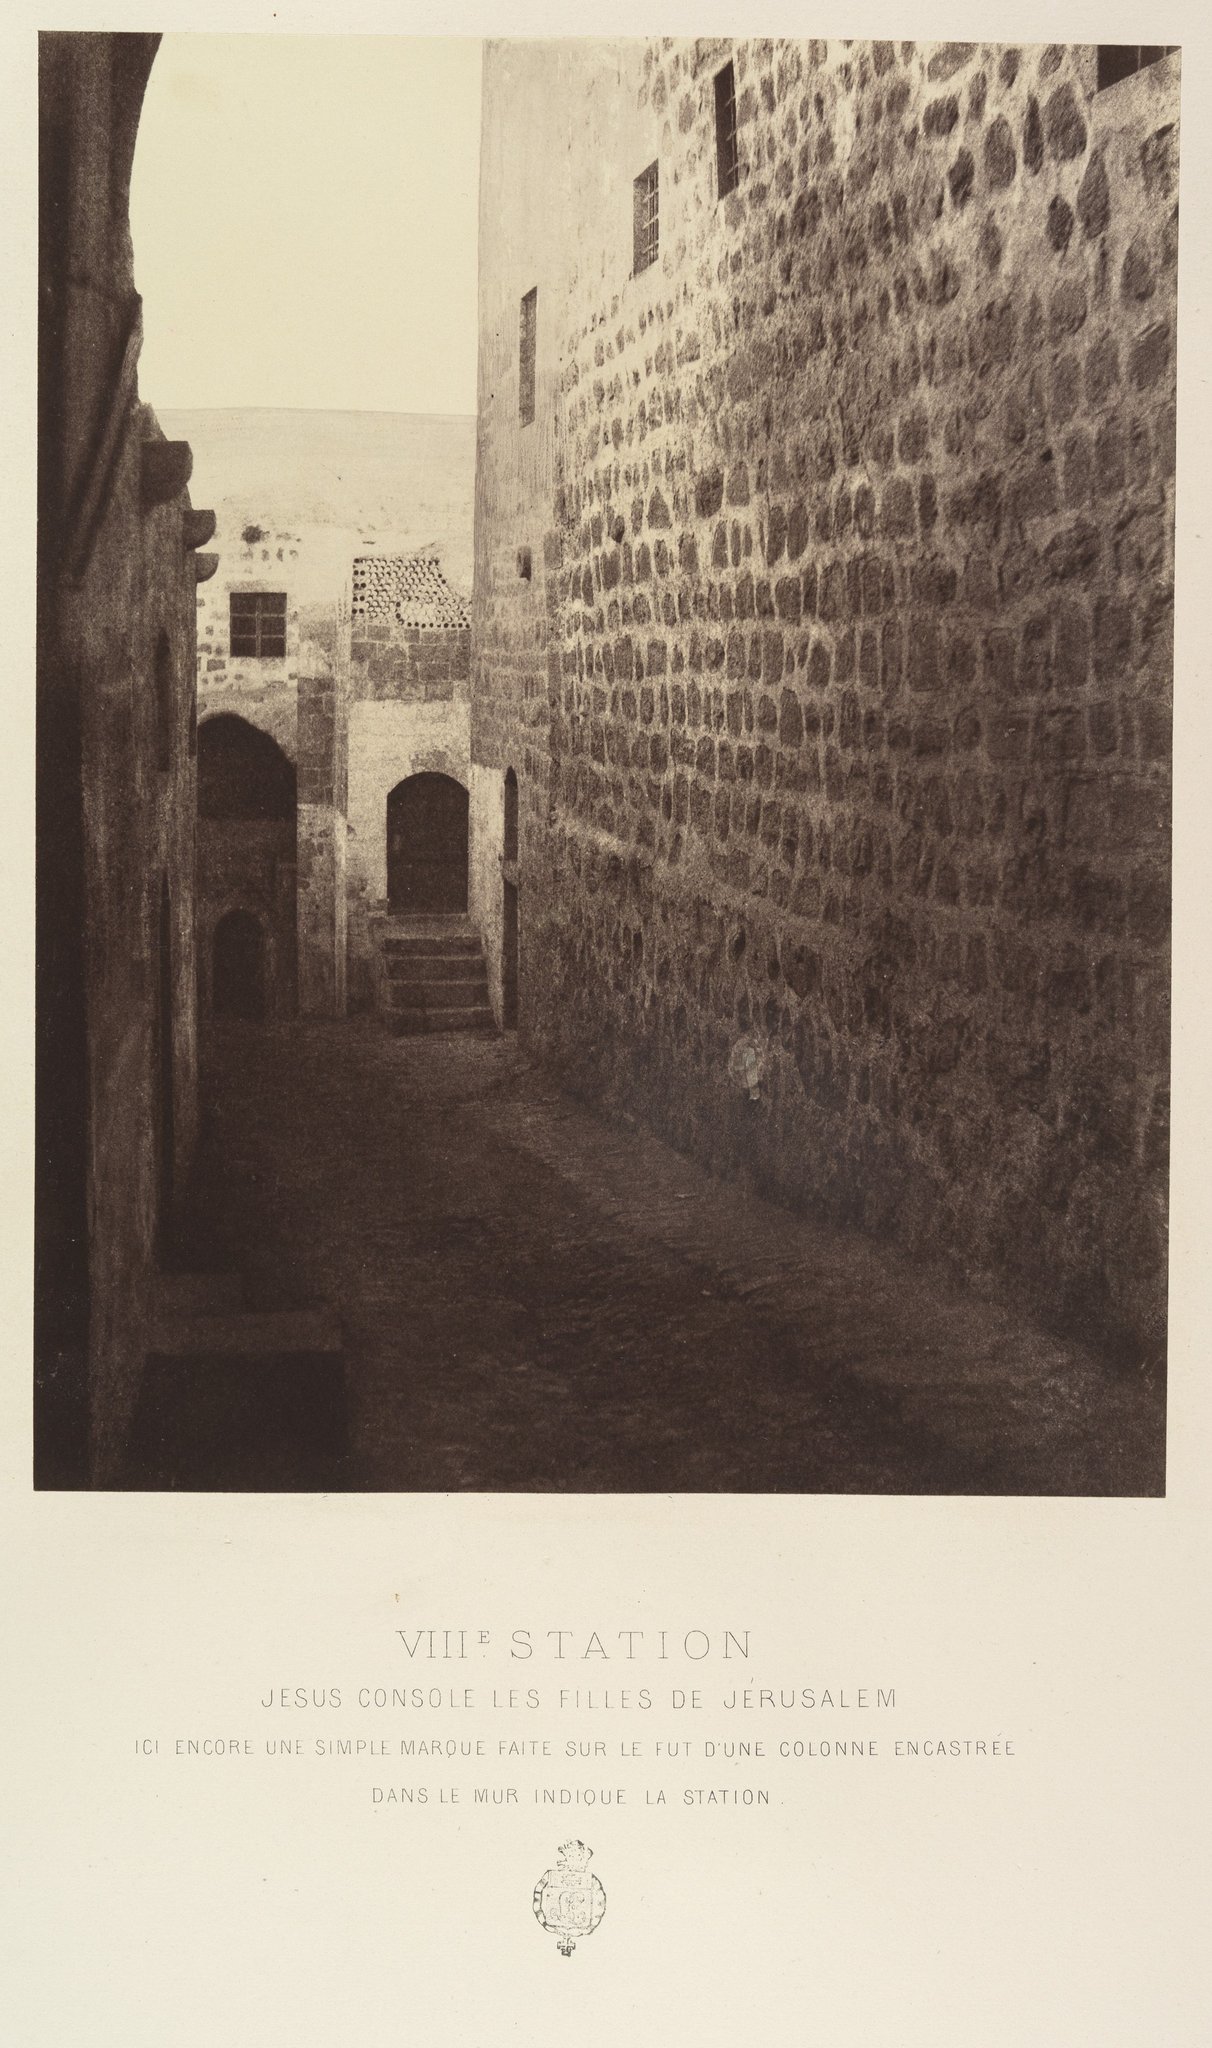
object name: photograph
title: VIIIe Station. Jésus console les filles de Jérusalem. Ici encore une simple marque faite sur le fut d'une colonne encastrée dans le mur indique la station.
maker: louis de clercq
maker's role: artist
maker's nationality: french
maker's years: 1837-1901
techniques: albumen silver print, paper negative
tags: architecture,buildings